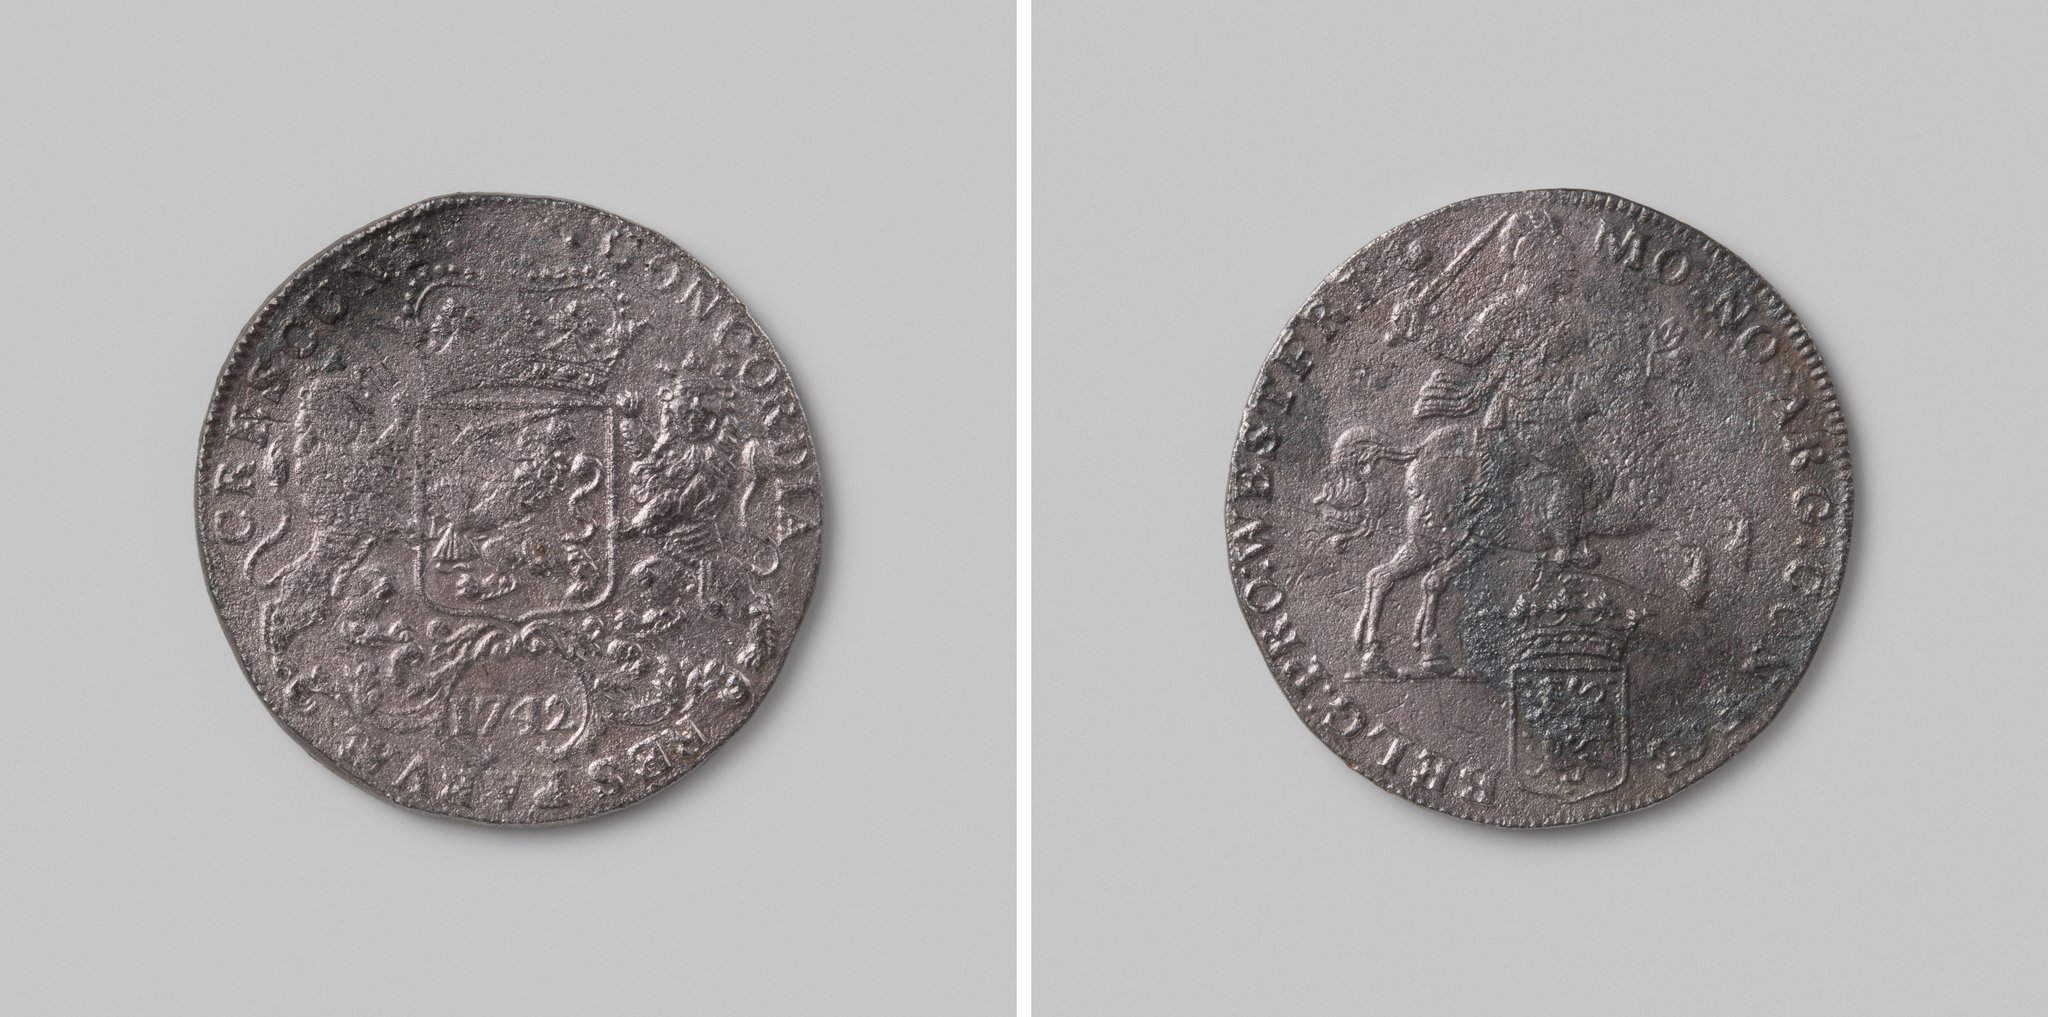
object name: coin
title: Zilveren rijder uit het wrak van de Oost-Indiëvaarder Hollandia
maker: Anonymous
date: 1742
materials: silver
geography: west frisia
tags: verenigde oostindische compagnie, hollandia (schip), annet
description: Economic objects, coin, sinver rider (1) id. NG 1975-55H (4.1d, 0.25t), coin.